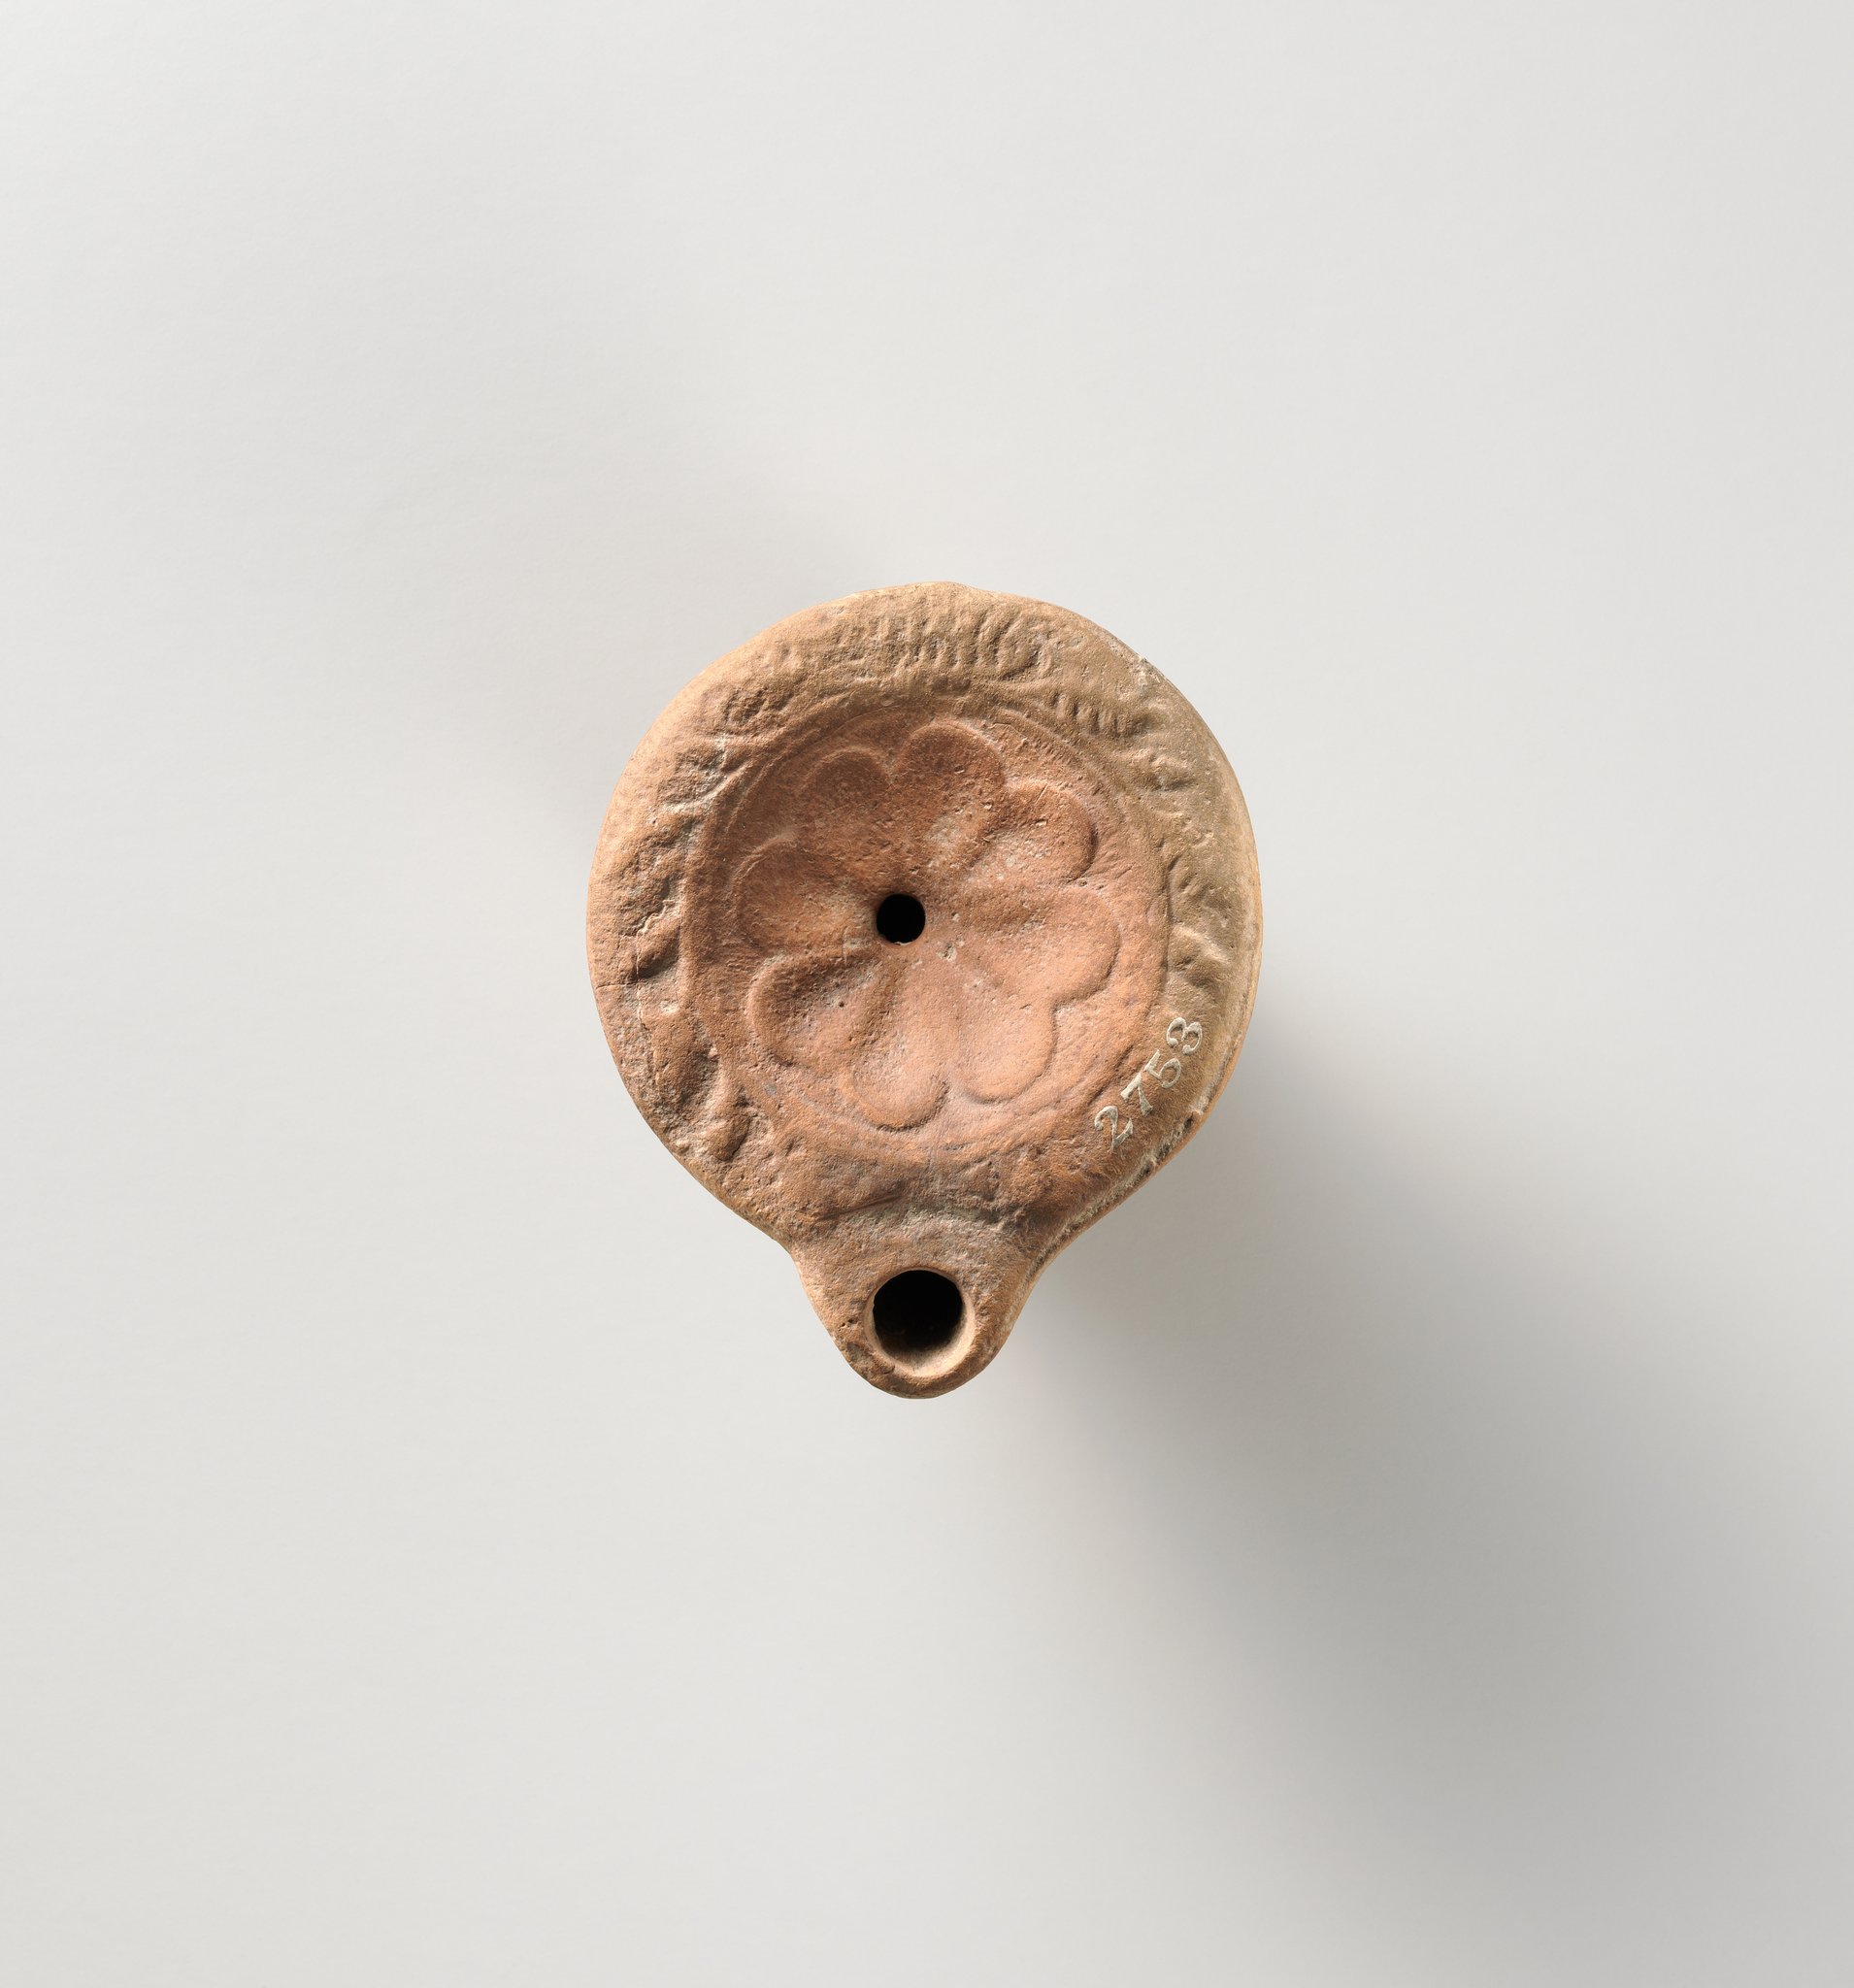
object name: lamp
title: Terracotta oil lamp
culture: roman, cnidian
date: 101-200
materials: terracotta